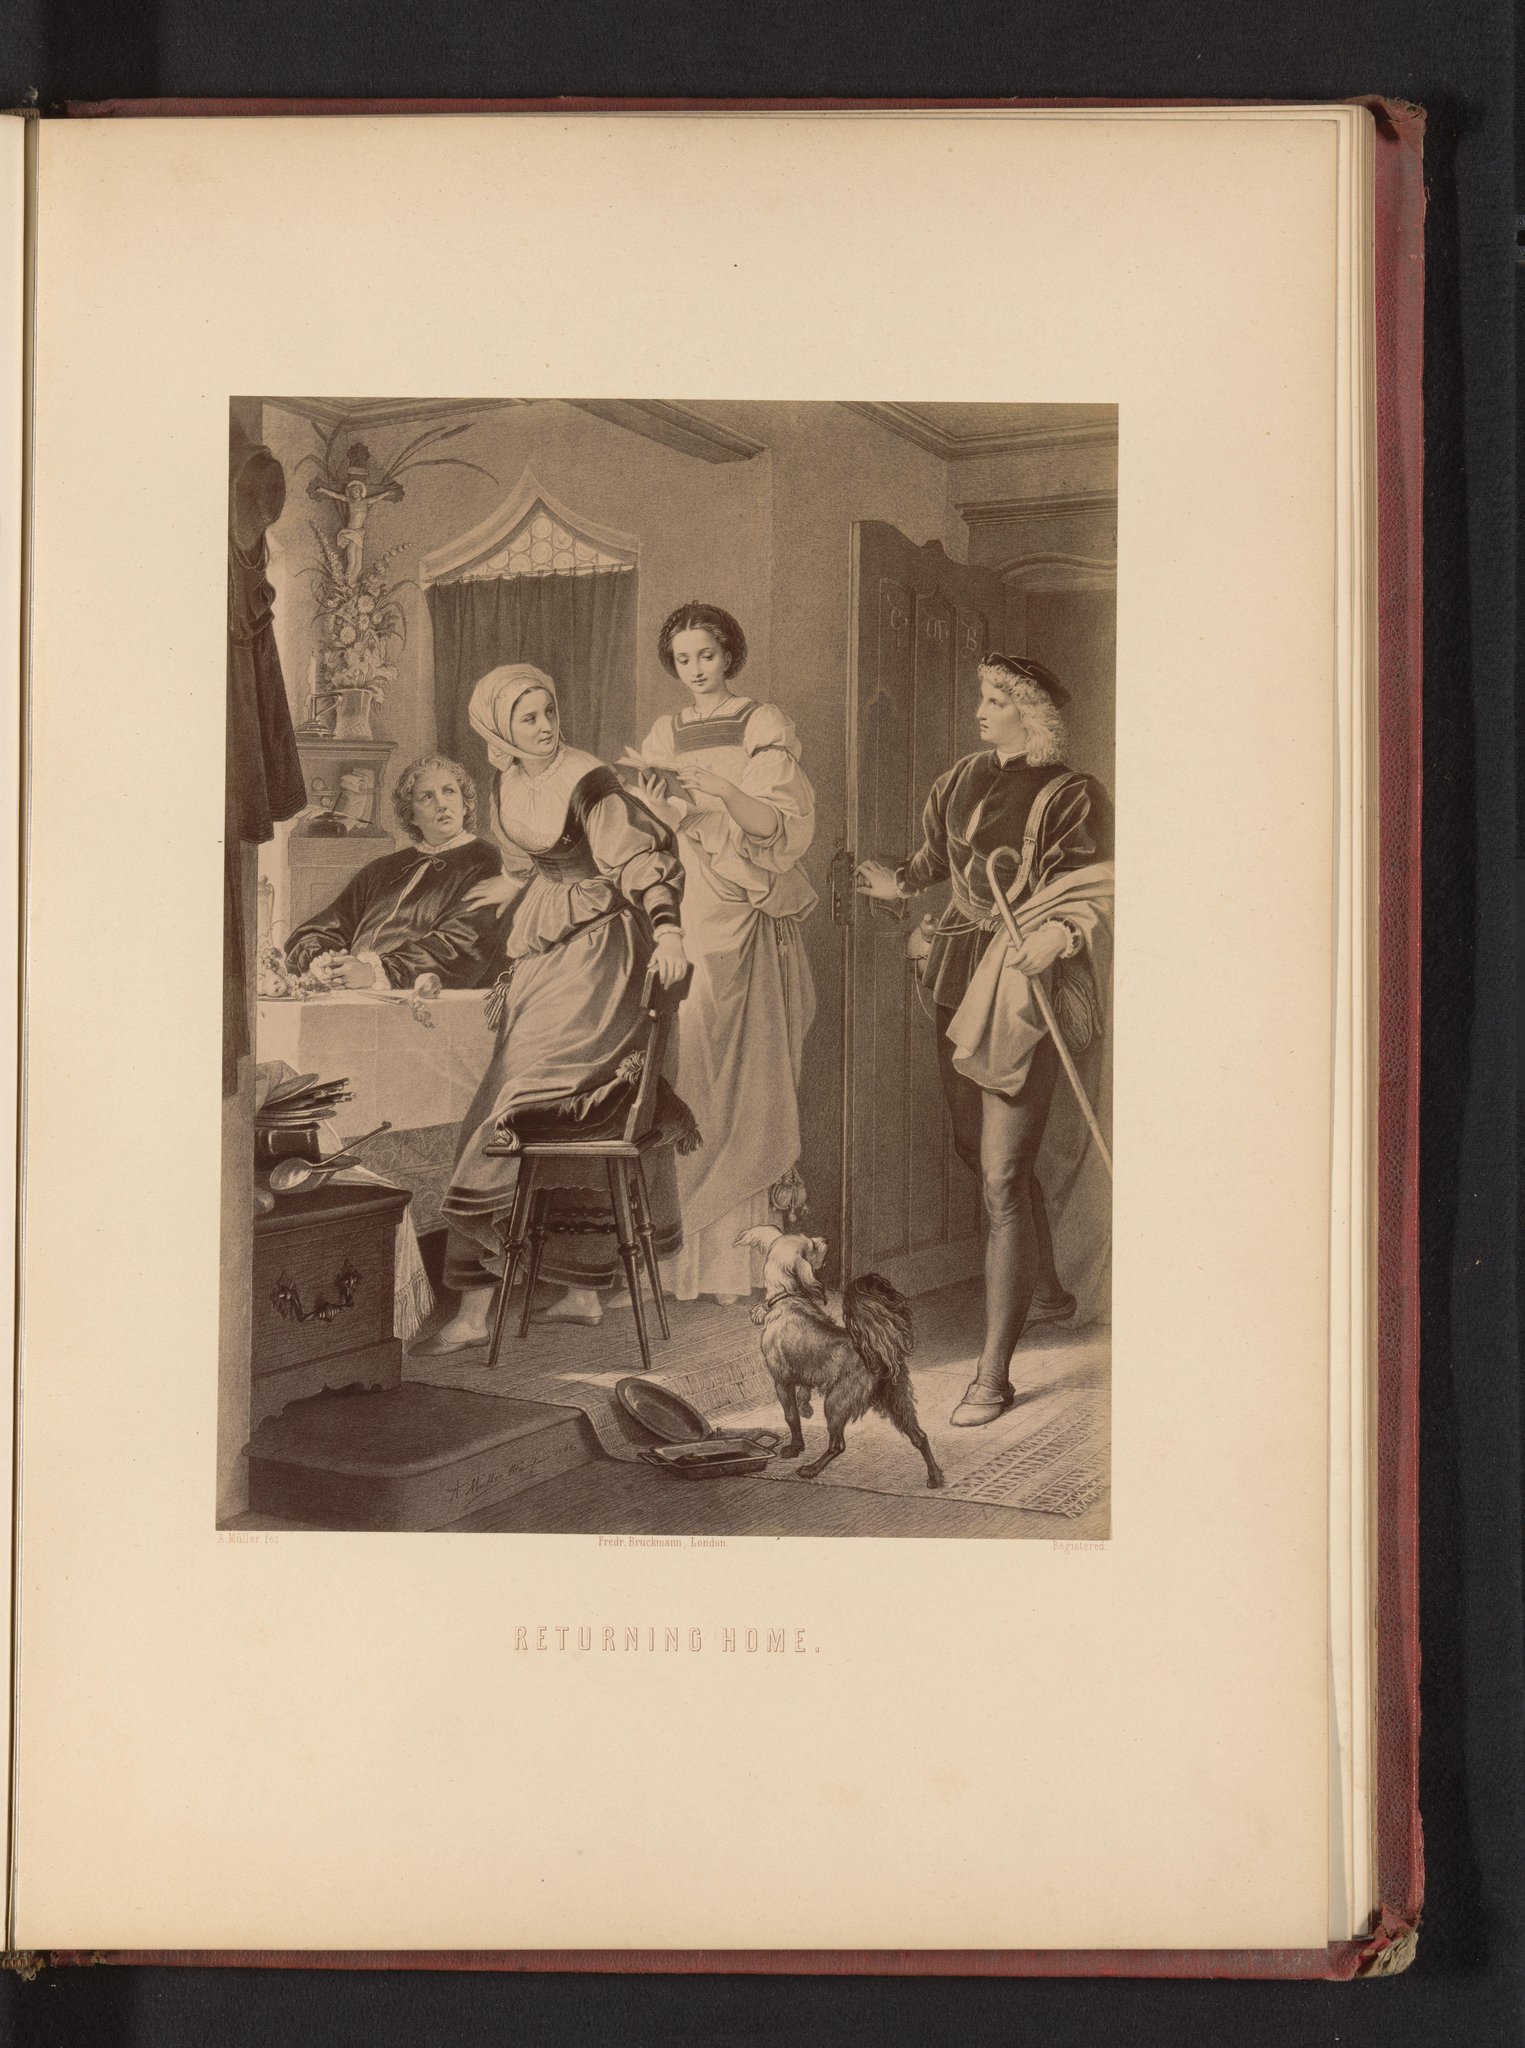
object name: photograph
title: Returning home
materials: photographic support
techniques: albumen print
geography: london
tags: arrival and return ~ travelling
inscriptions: inscription: ‘Registered.’